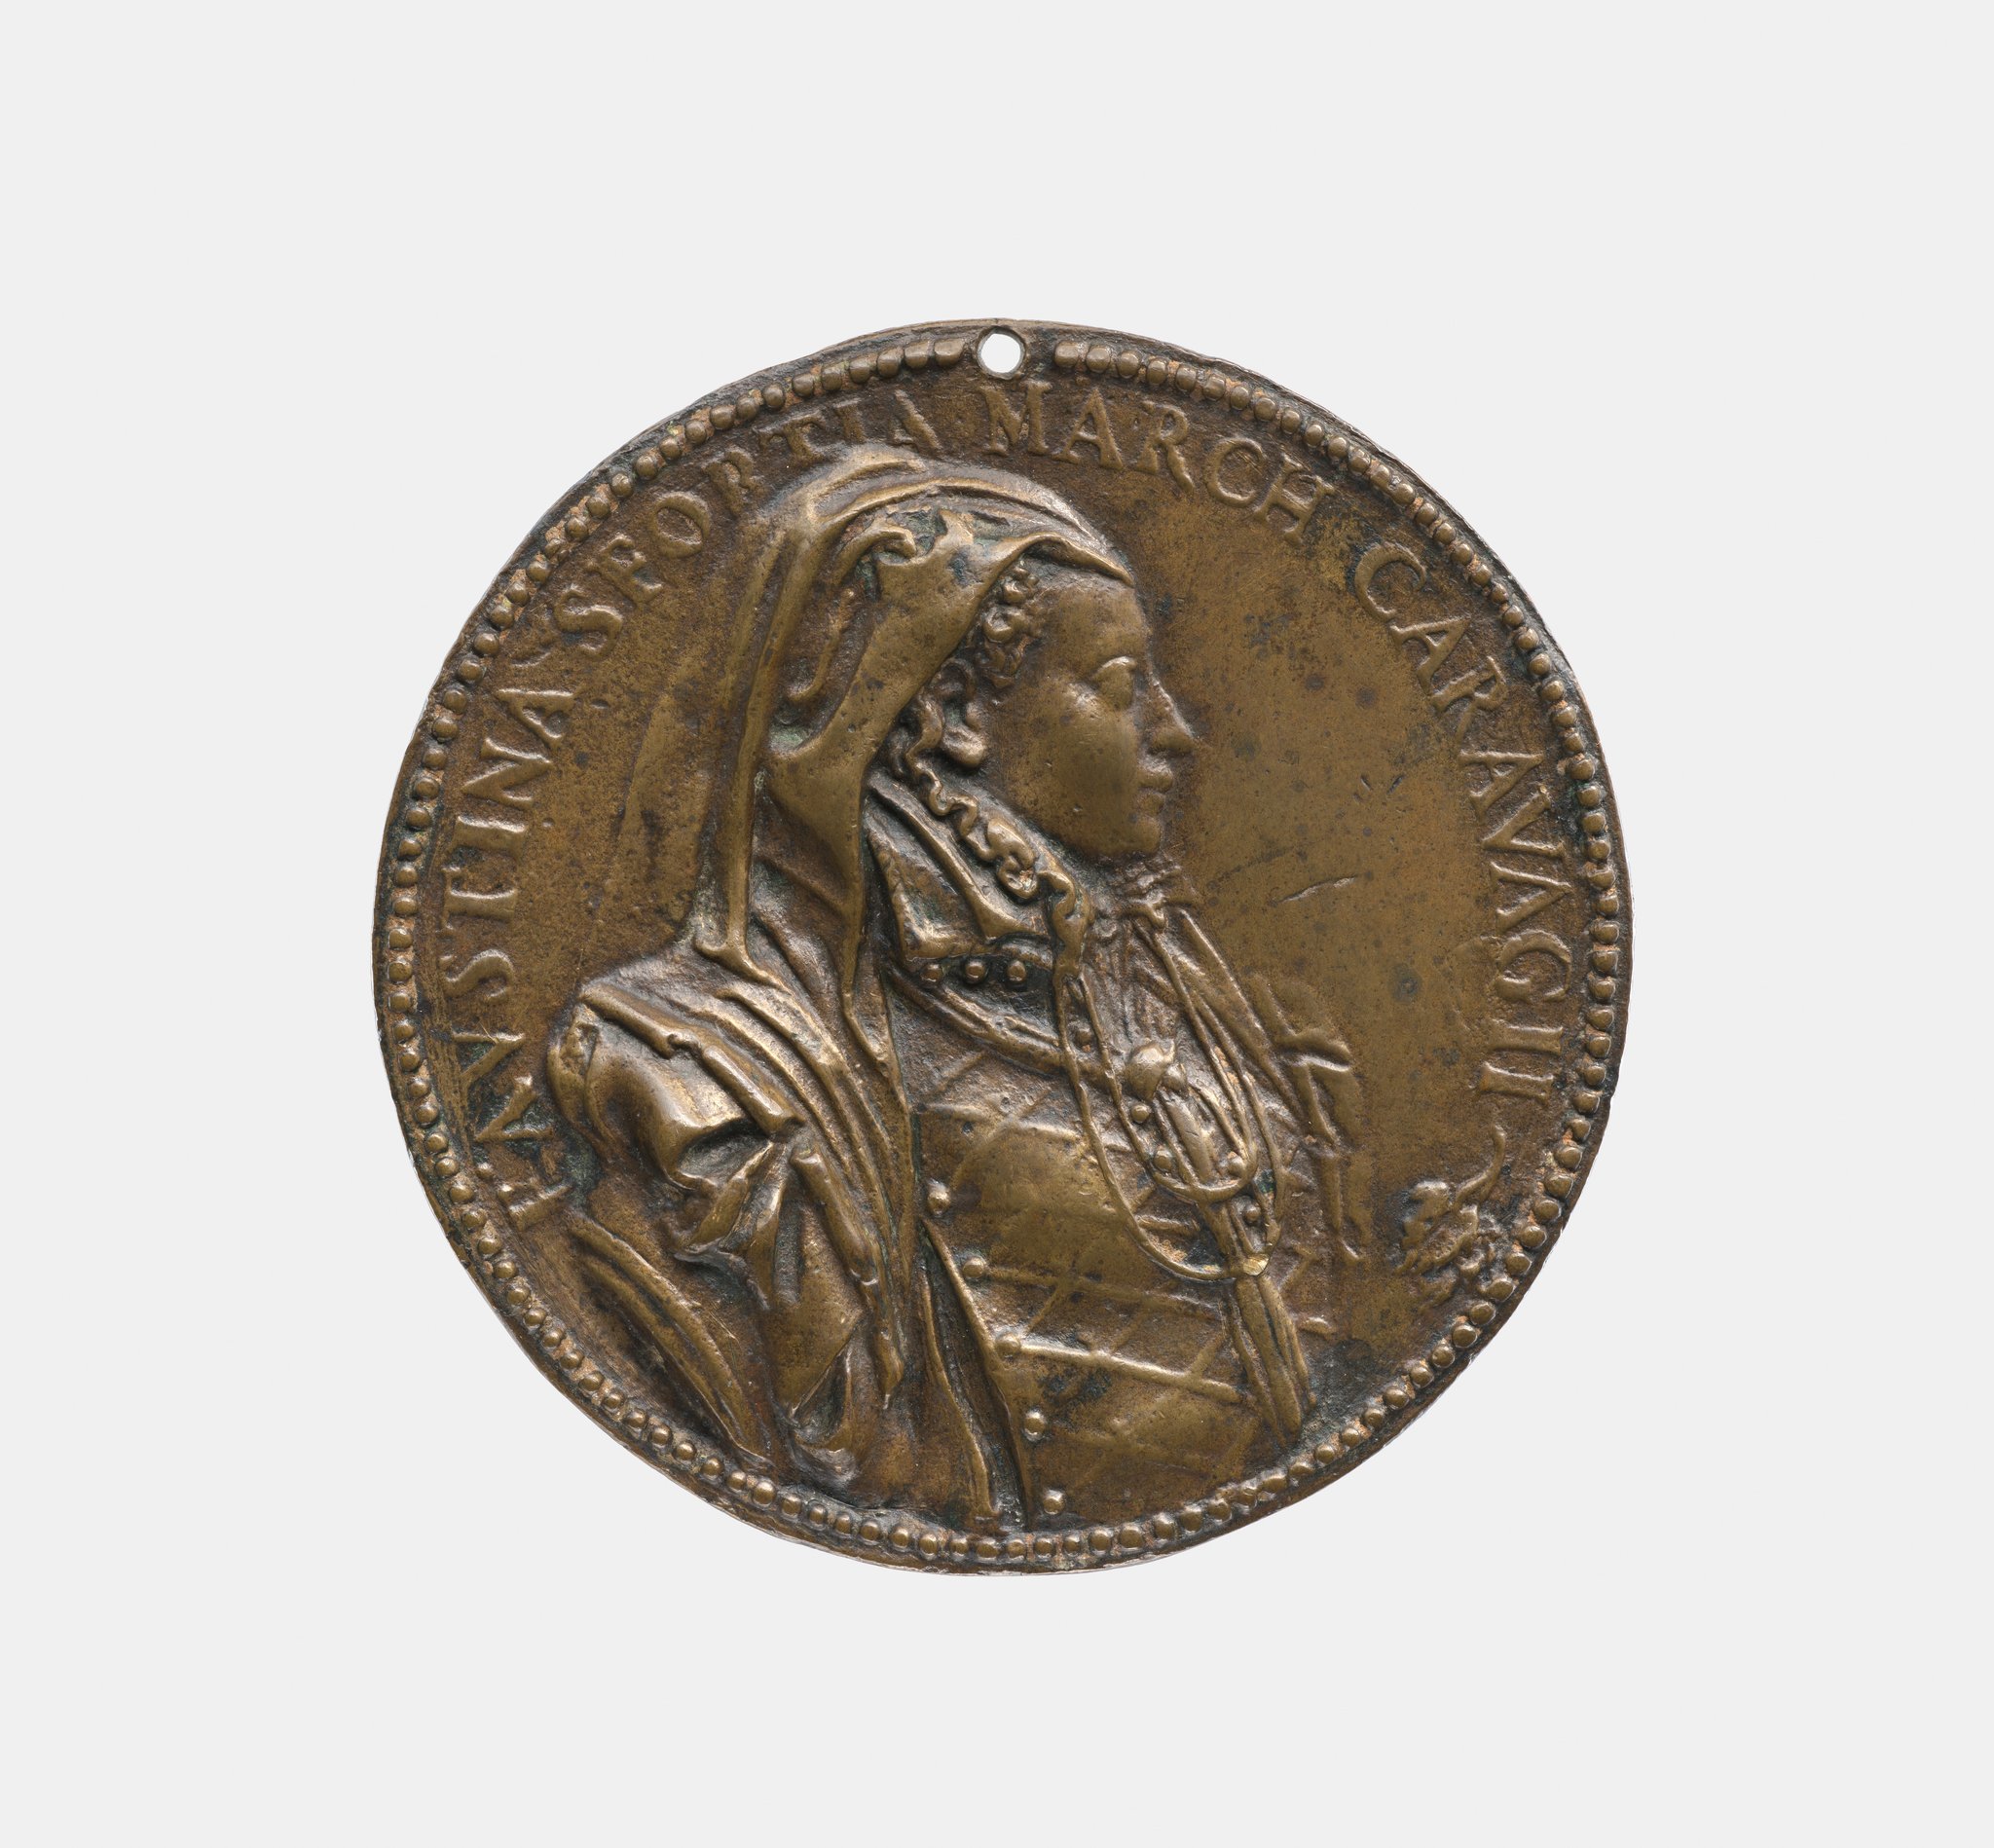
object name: medal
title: Faustina Sforza, Marchesa of Caravaggio, married 1546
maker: pietro paolo galeotti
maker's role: artist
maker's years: 1500-1600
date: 1532-1584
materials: bronze